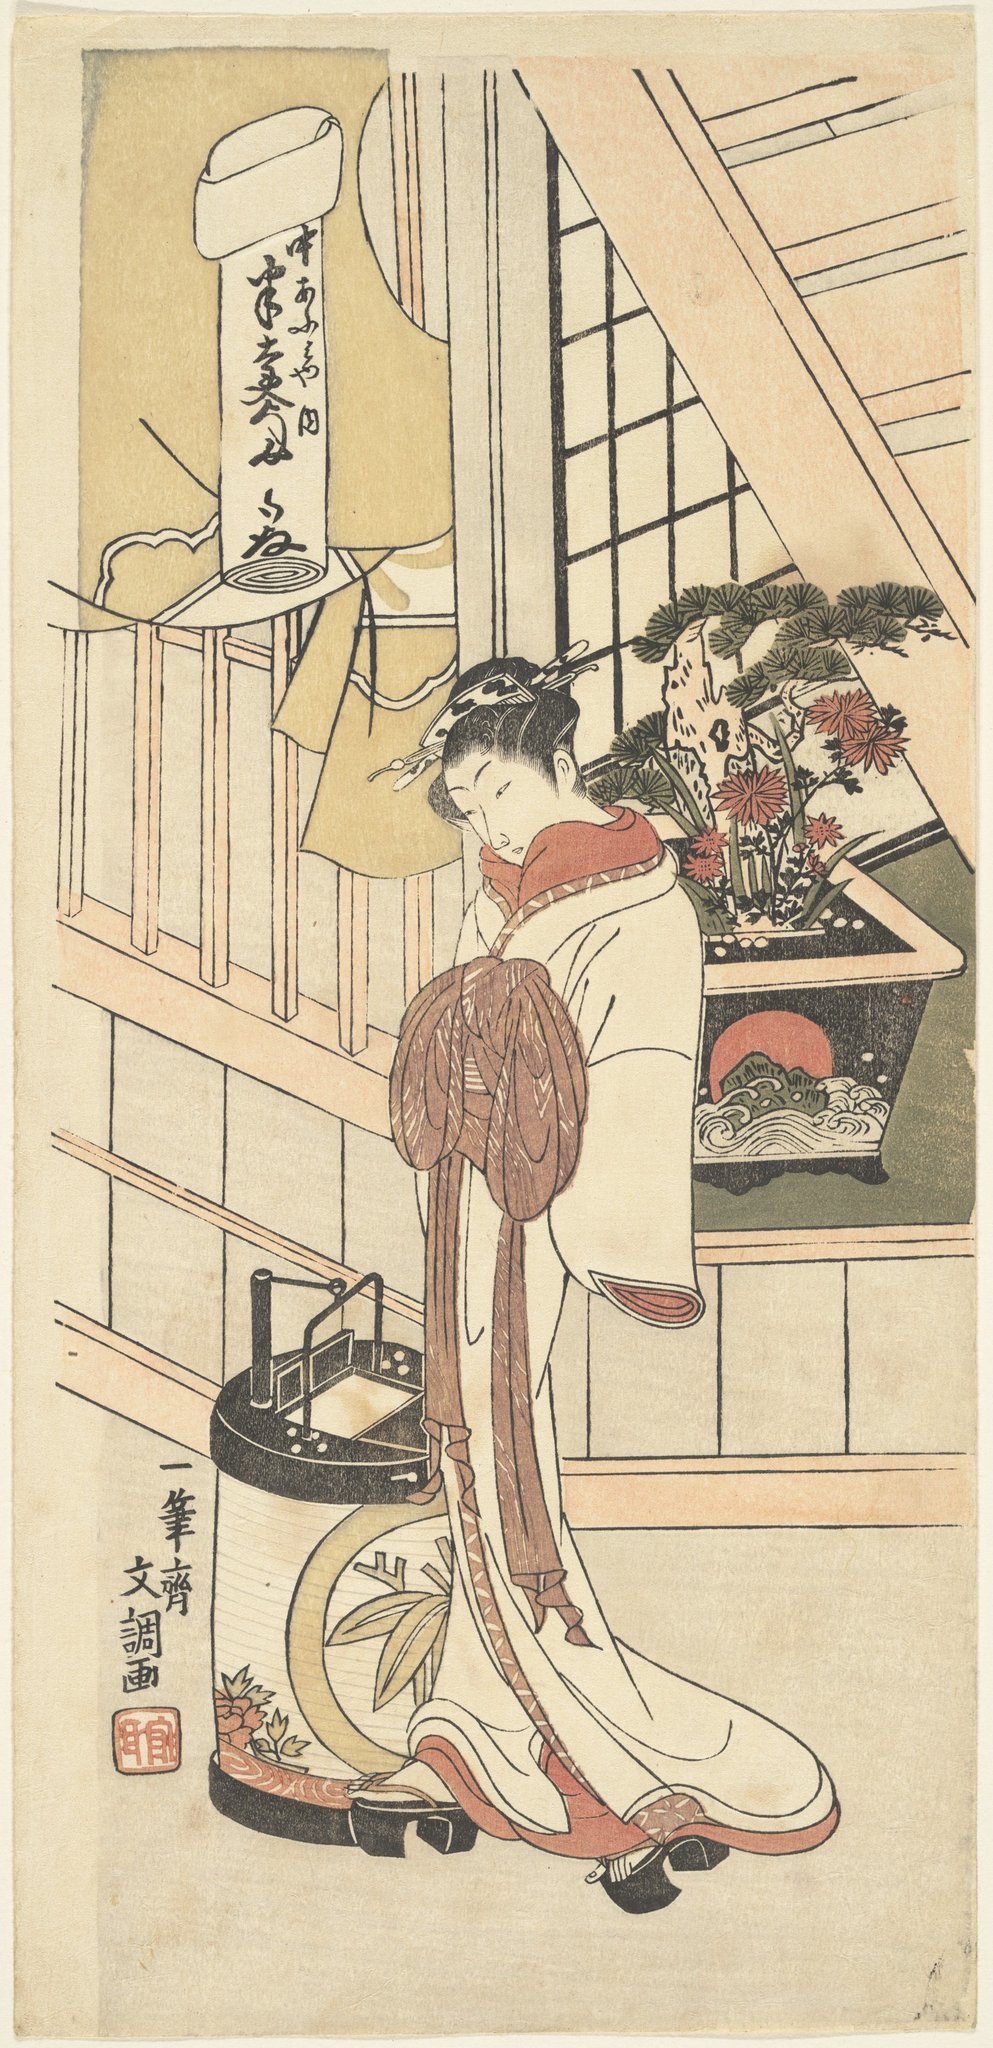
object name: woodblock print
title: Handayu, An Actor in a Female Role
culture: japanese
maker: ippitsusai bunchō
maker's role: artist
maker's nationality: japanese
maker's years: 1765-1792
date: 1723-1792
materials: ink, paper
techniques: woodblock print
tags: men,women,actors,lanterns